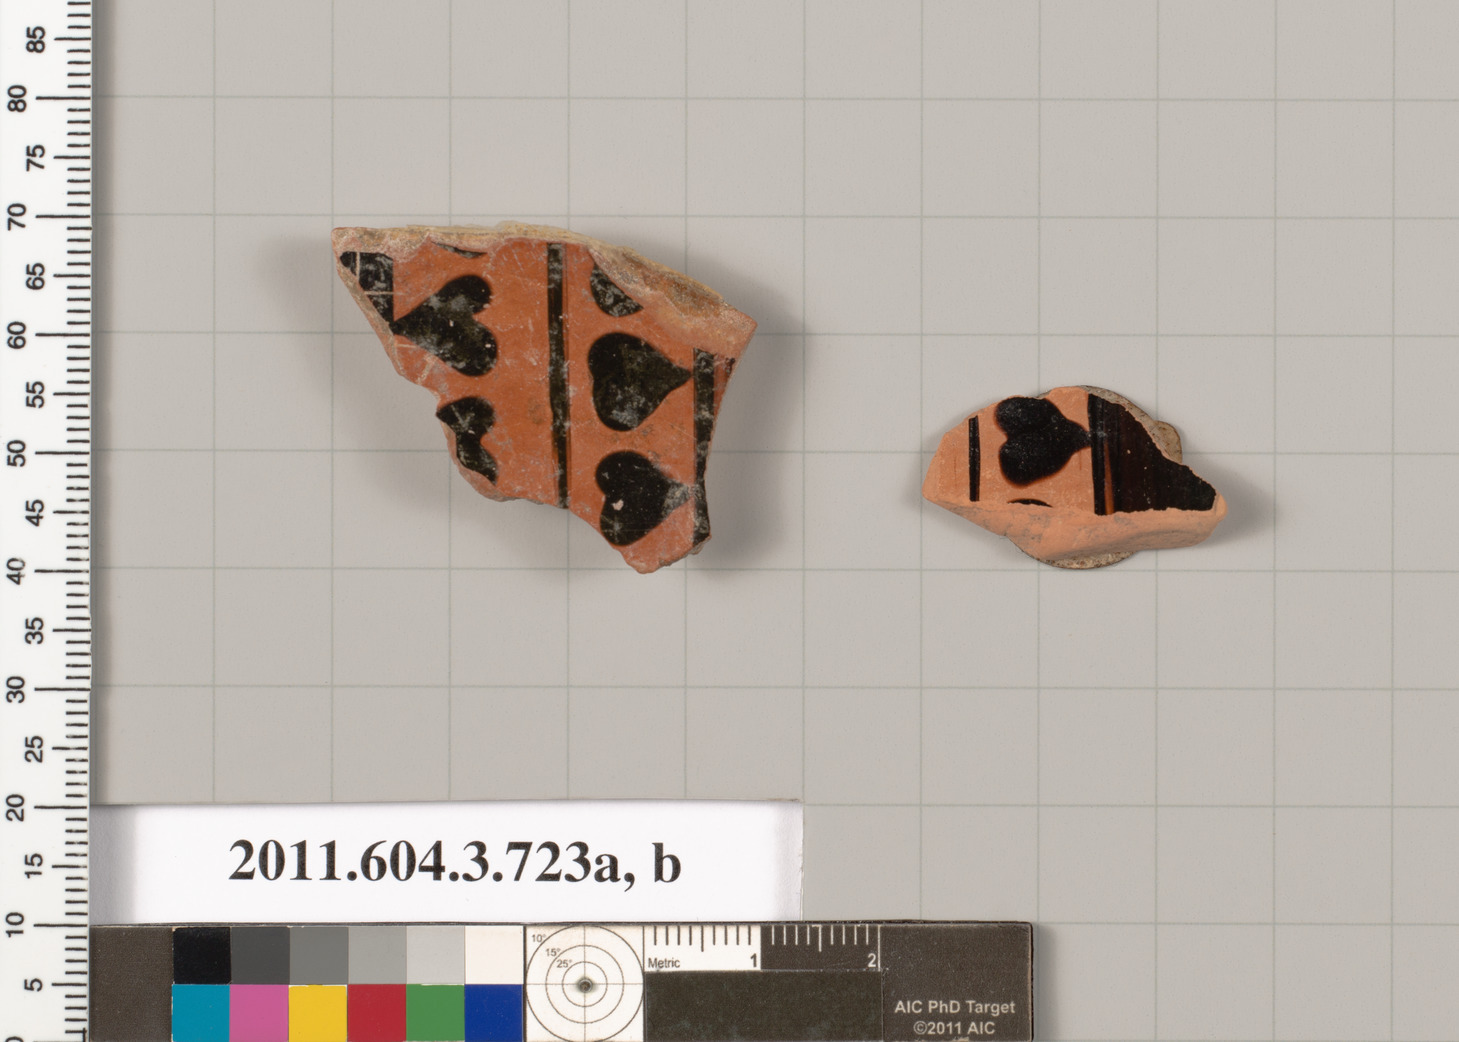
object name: hydria fragment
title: Terracotta fragments of hydriai (water jars)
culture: greek, attic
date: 534-468 BCE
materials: terracotta